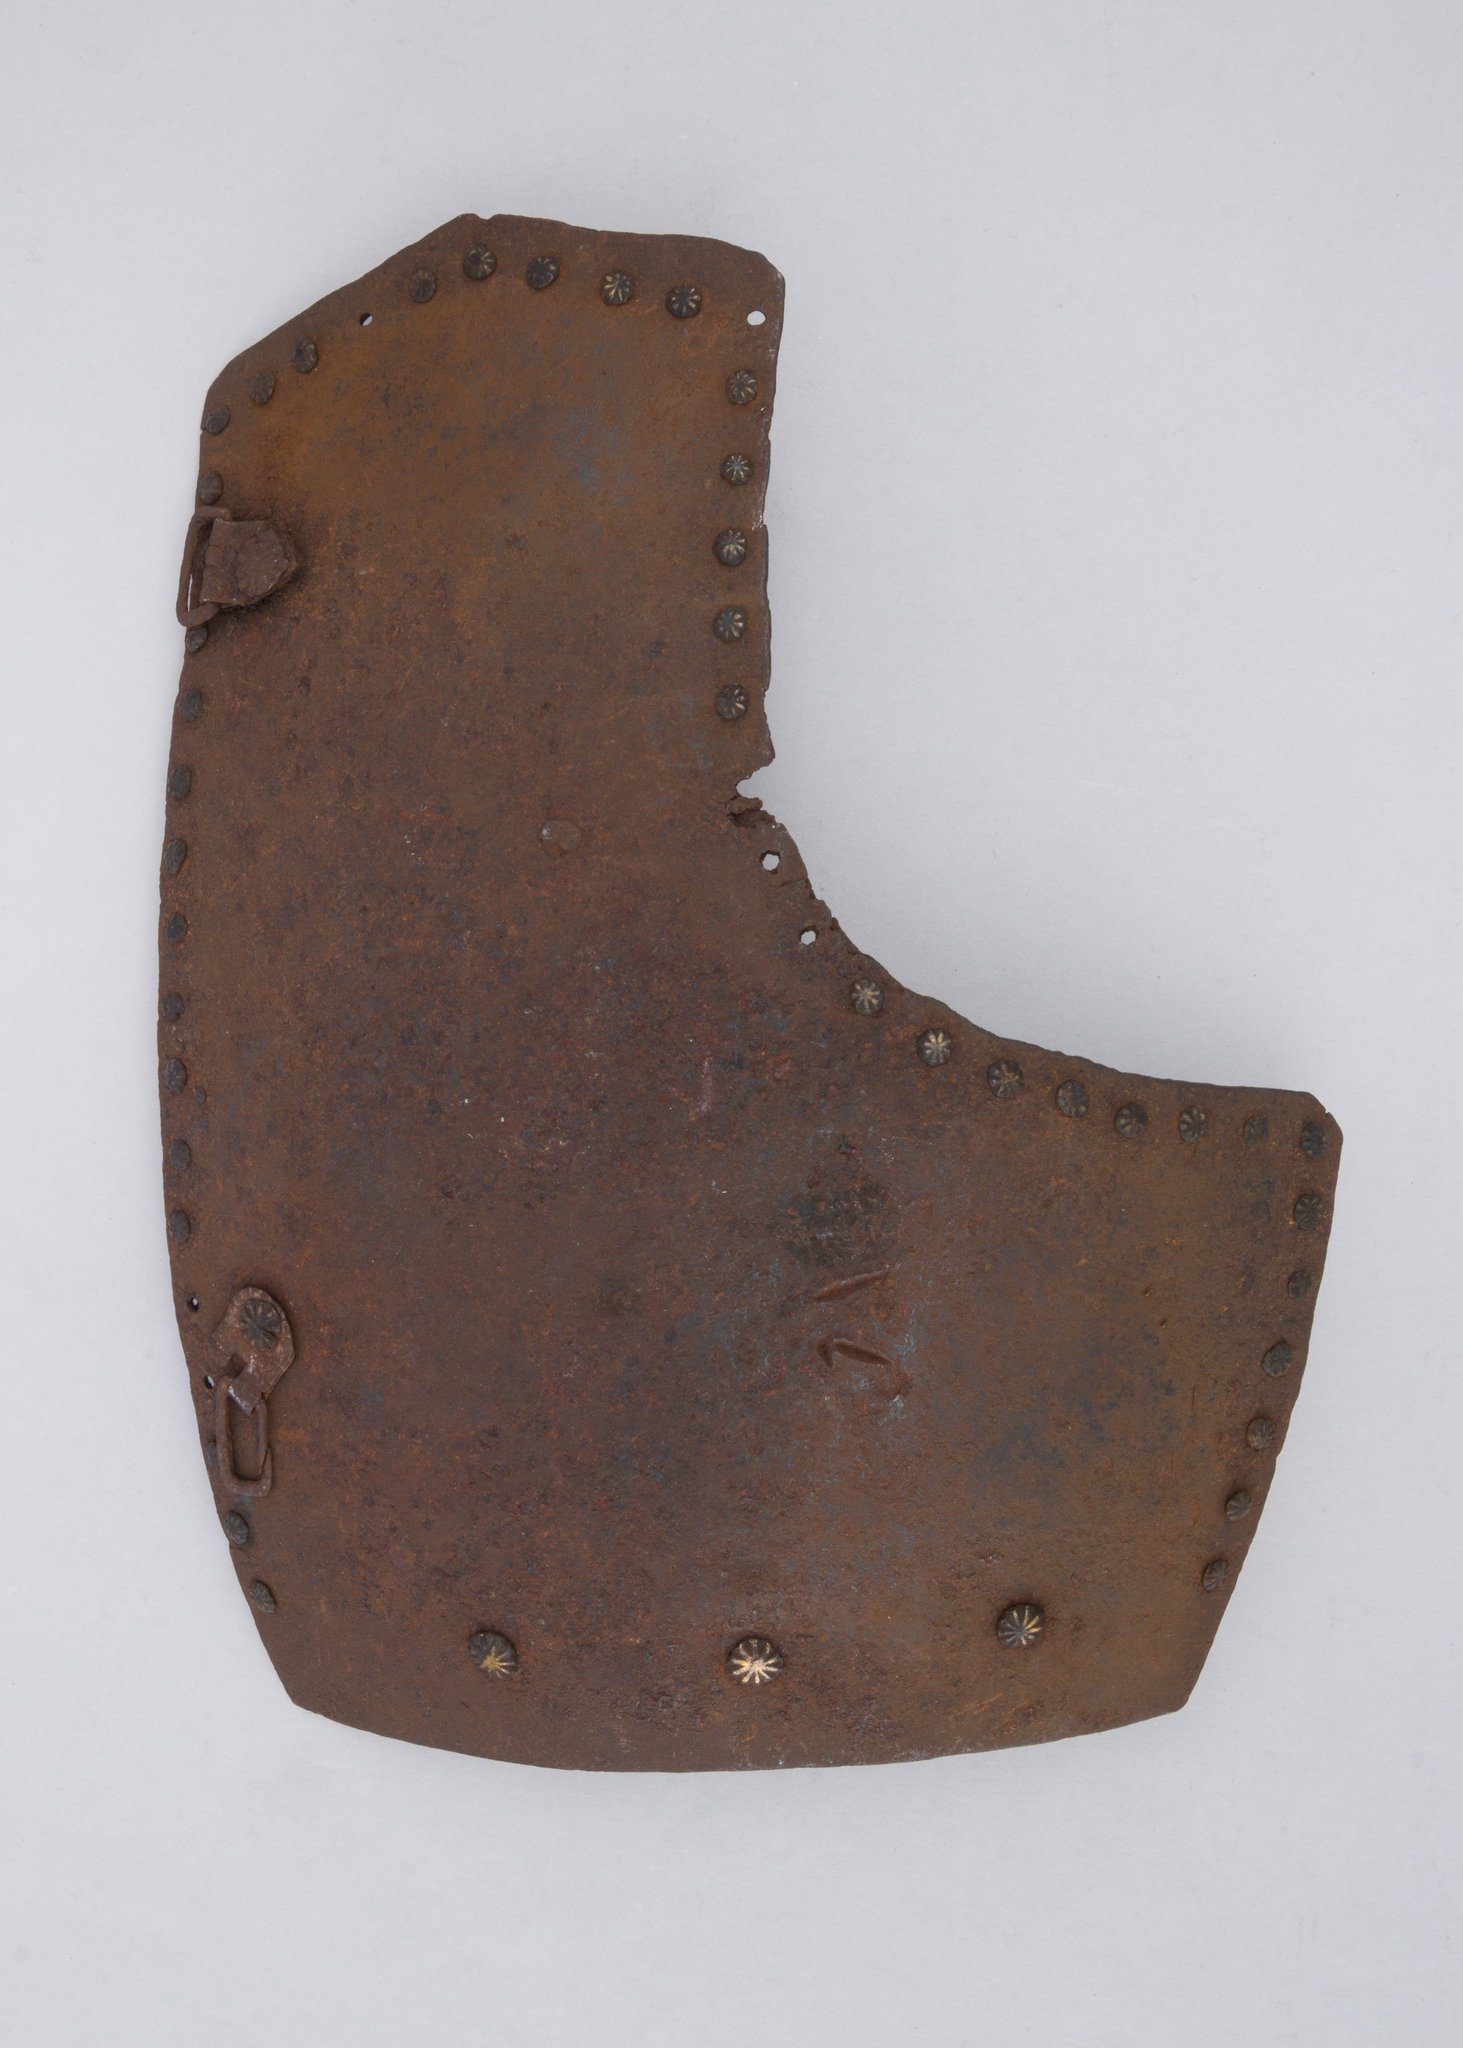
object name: brigandine plate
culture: italian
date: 1400-1450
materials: copper alloy, metal alloy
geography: italy